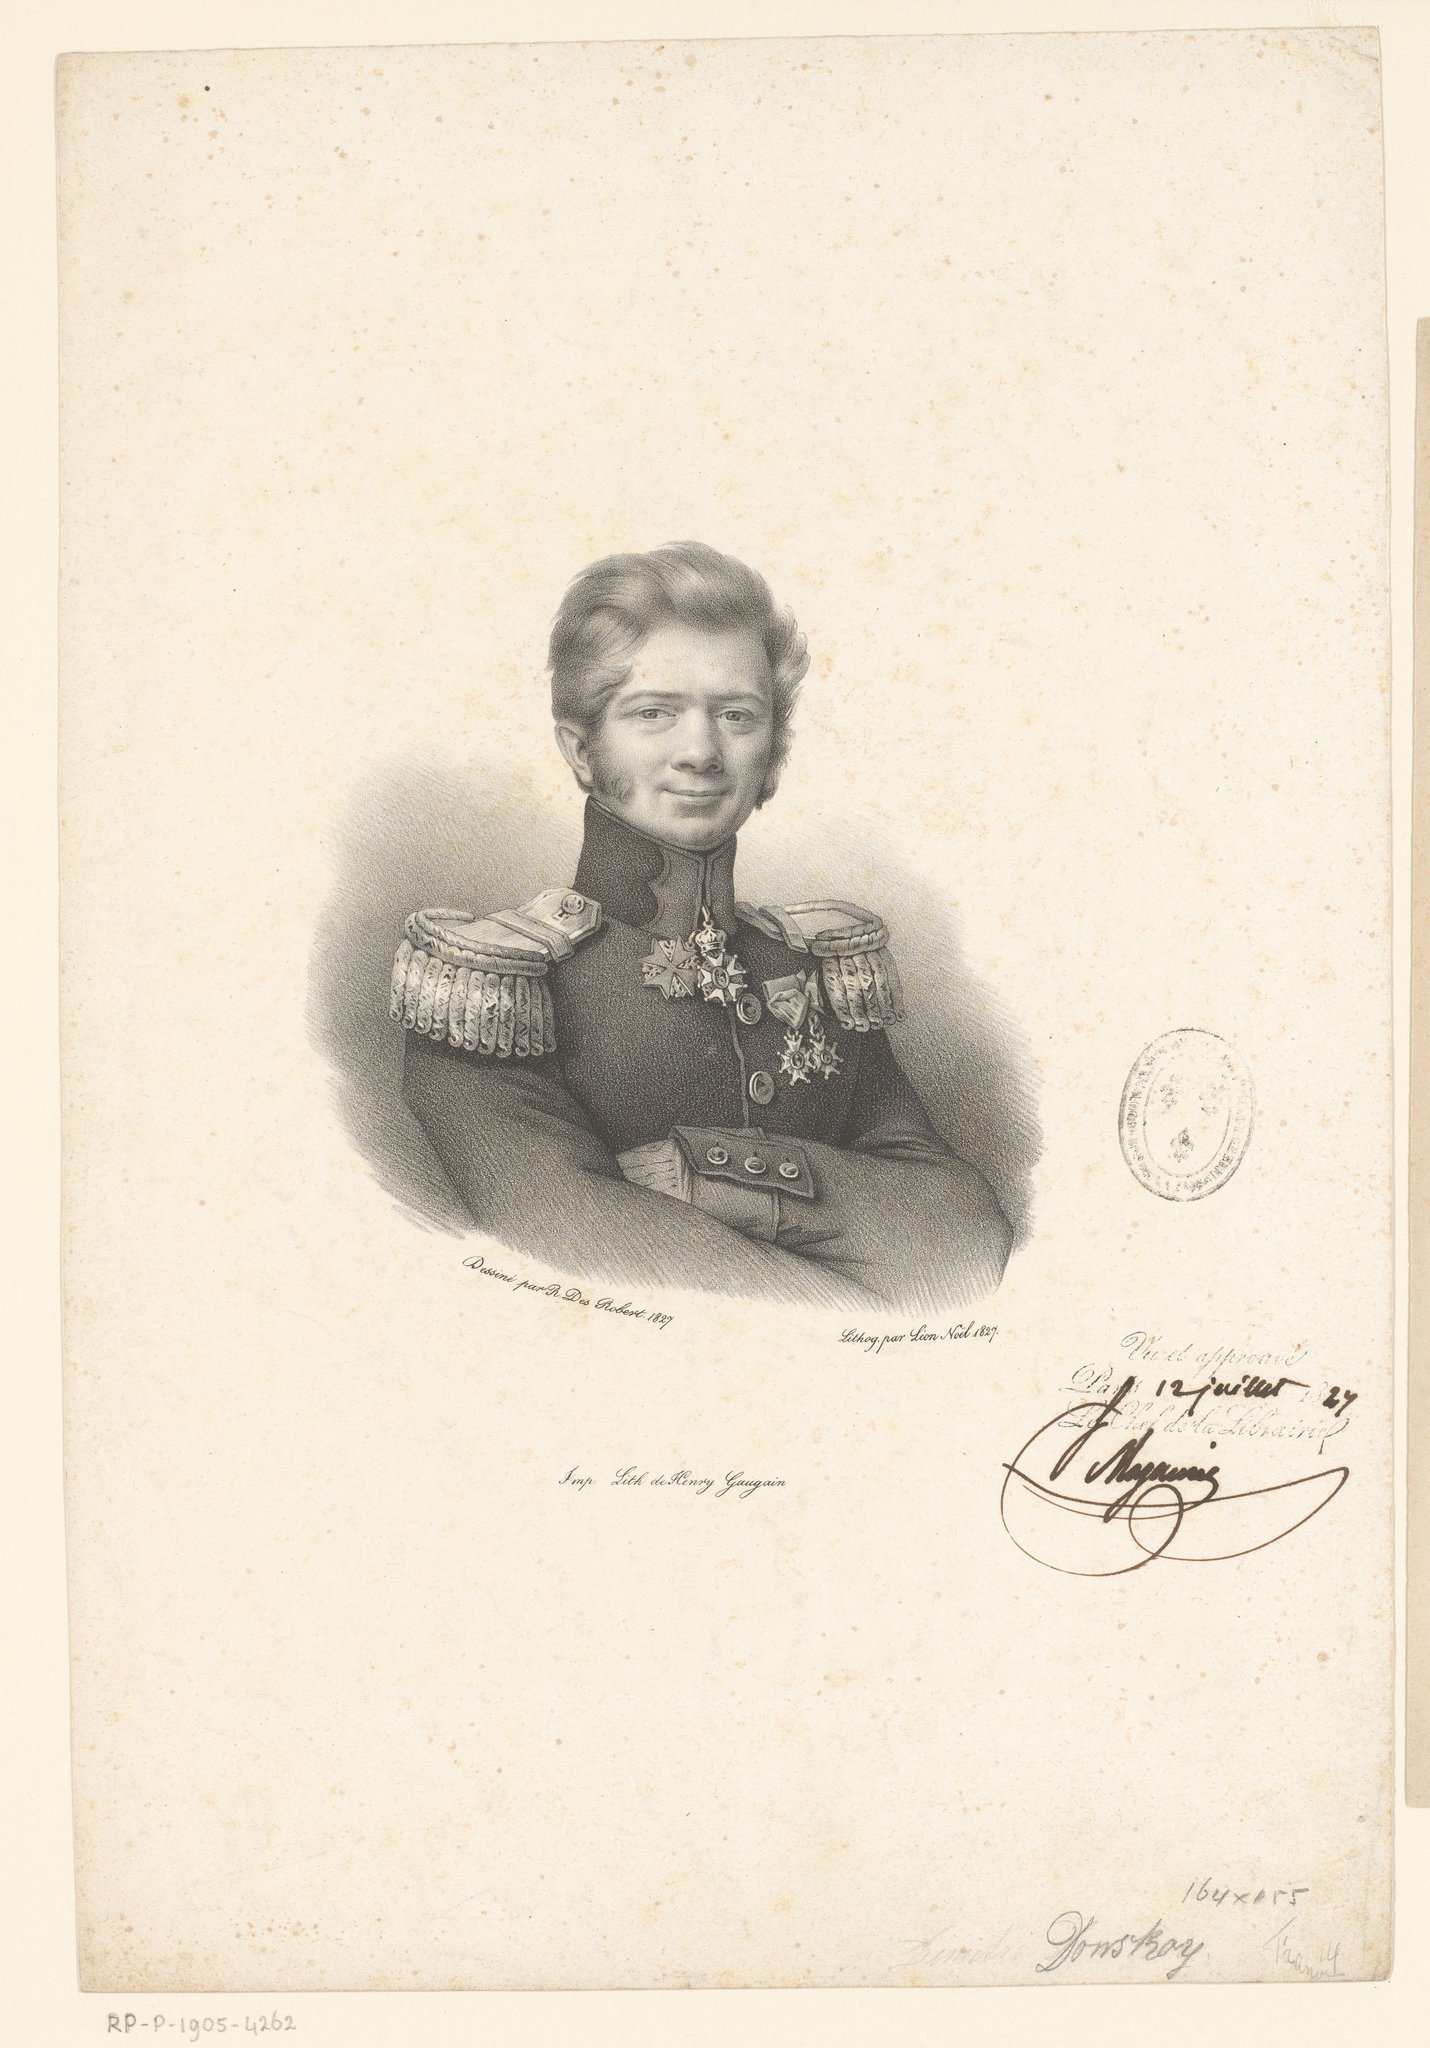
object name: print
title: Portret van onbekende man in uniform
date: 1827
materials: paper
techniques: lithograph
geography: paris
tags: historical persons (portraits and scenes from the life)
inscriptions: collector's mark: Lugt 2228, stamp, stamp: ‘Vu et approuvé/ Paris 12 juillet 1827/ Le Chef de la Librairie/ [...]’